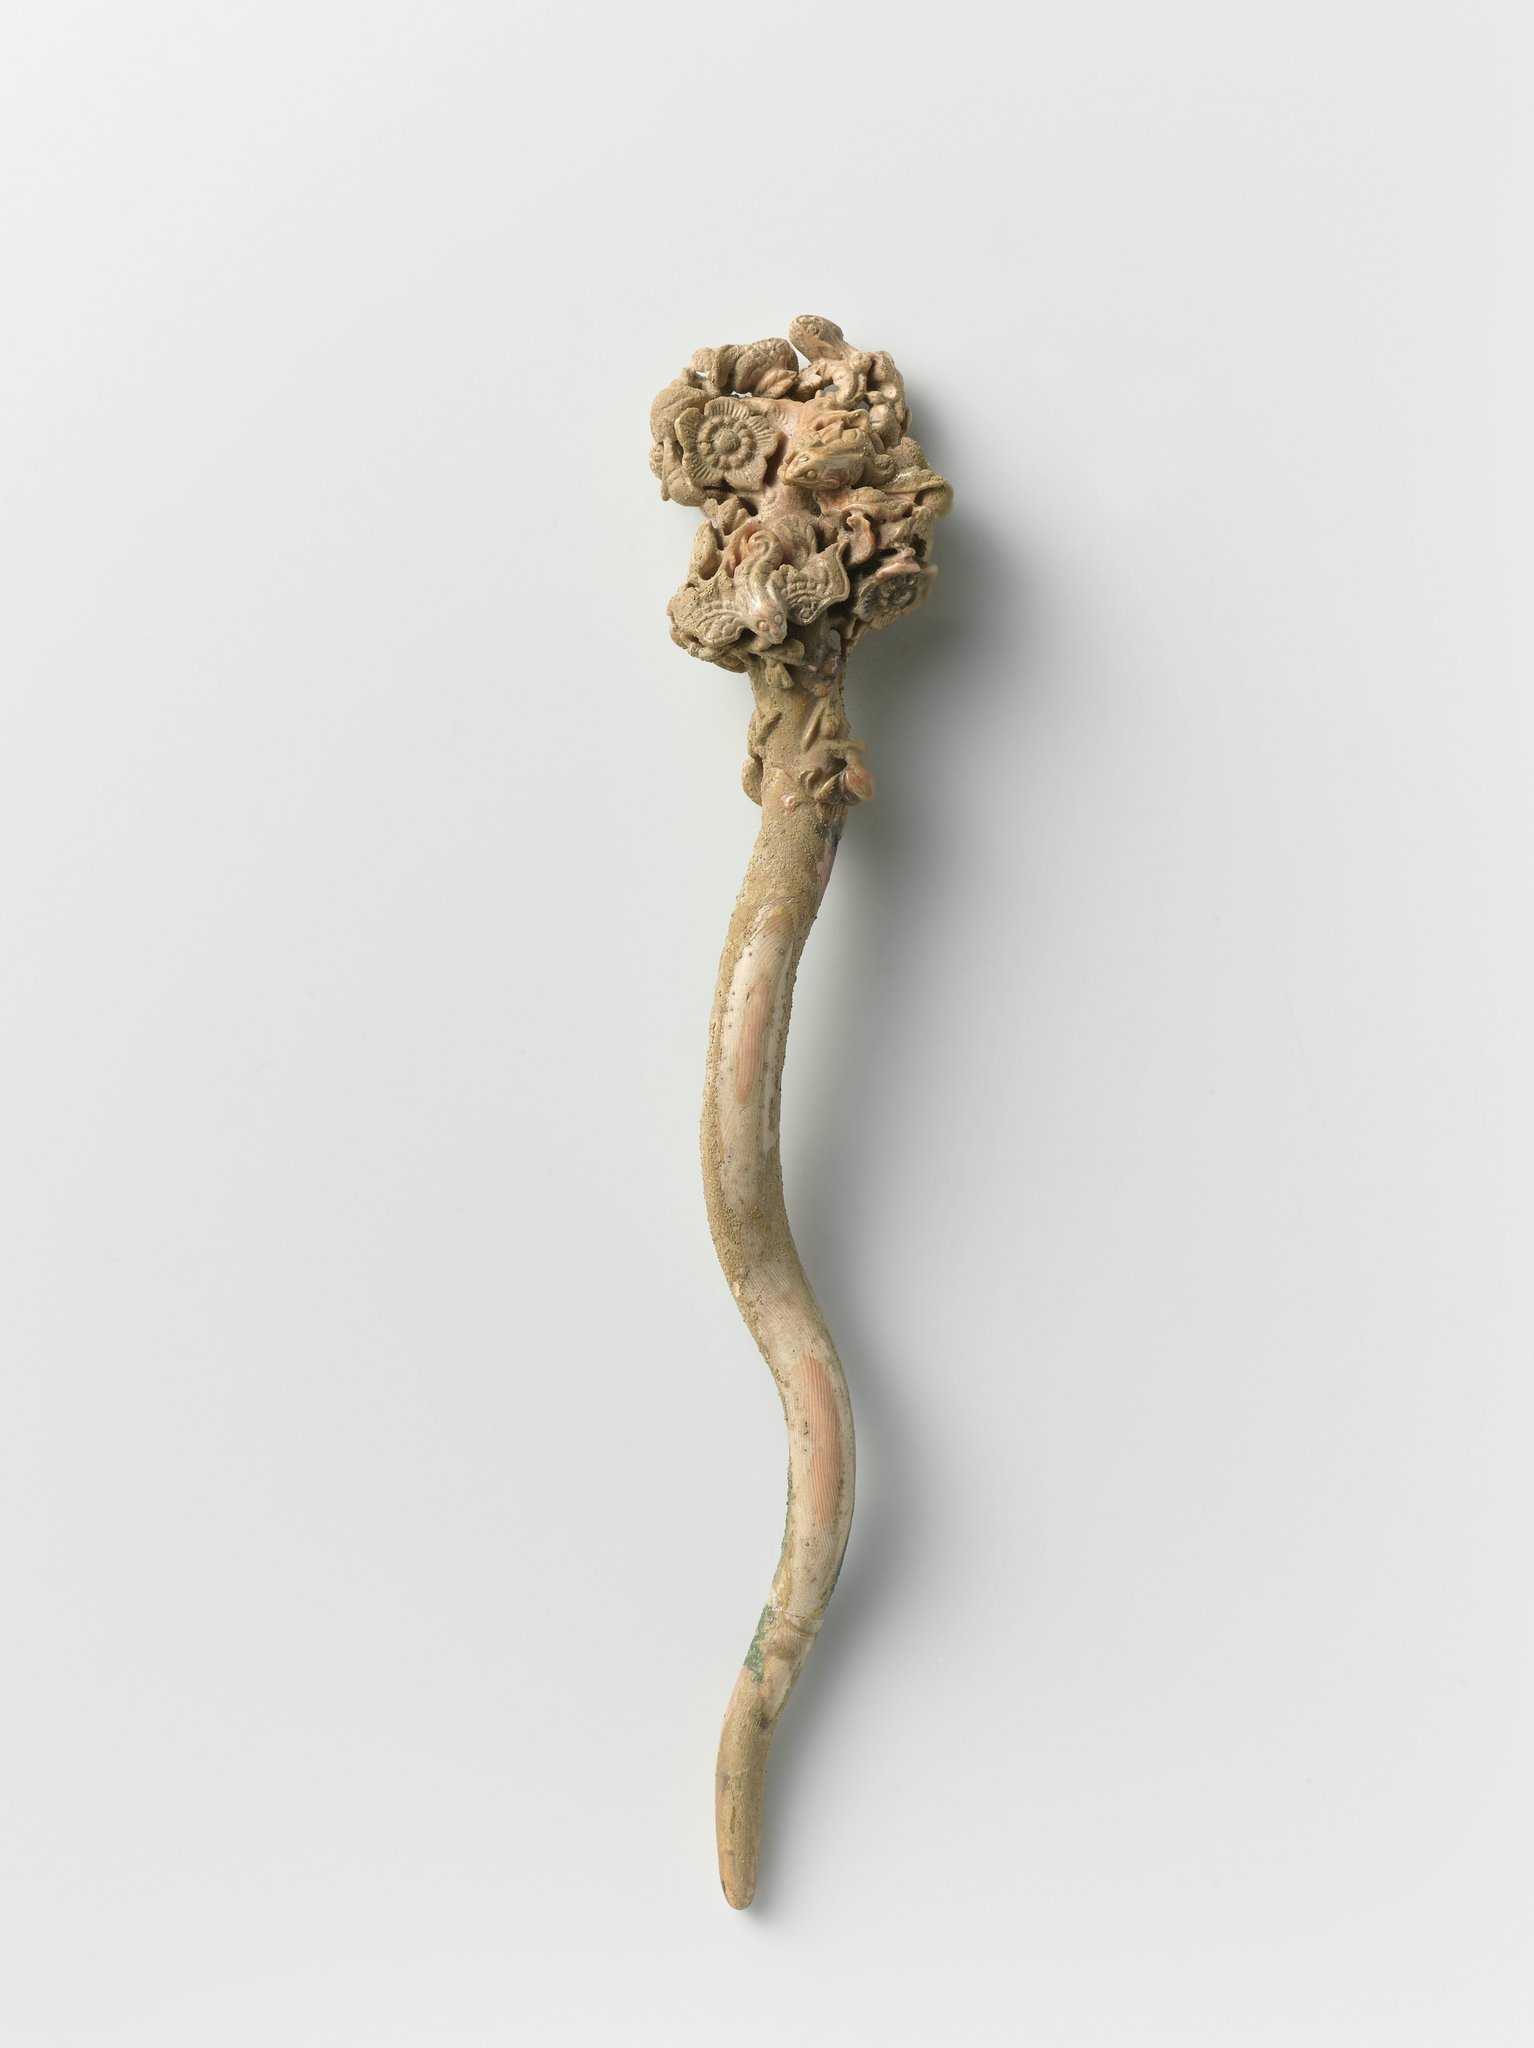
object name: hair ornament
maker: Anonymous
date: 960-1279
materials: coral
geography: china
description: Haarsieraad, in haut-reliëf versierd met vleermuizen en perziken.